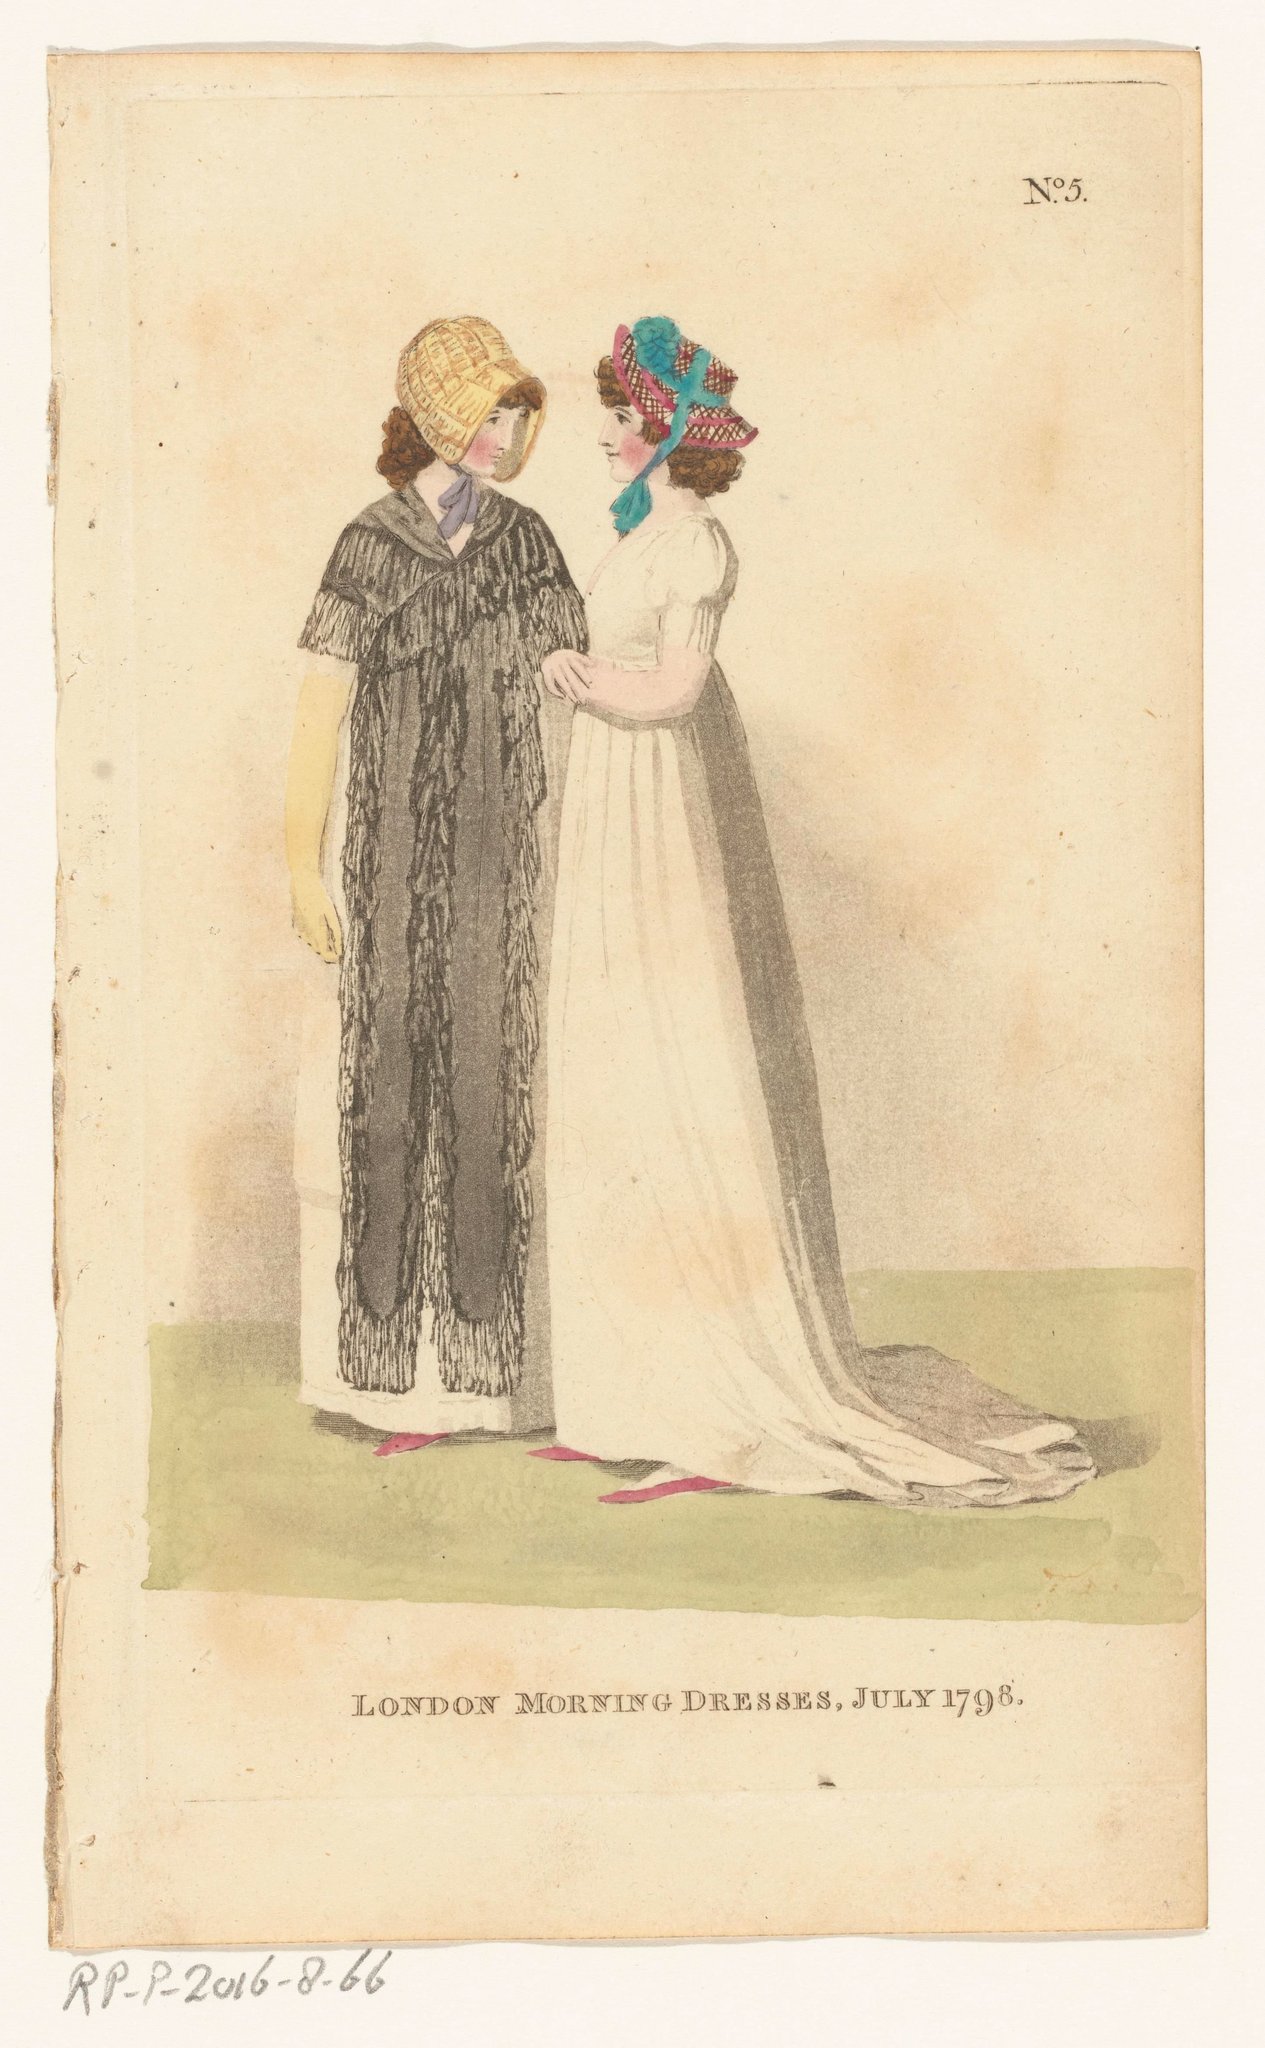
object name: fashion print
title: Magazine of Female Fashions of London and Paris, No. 5: London Morning Dresses, July 1798.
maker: richard phillips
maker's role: bookseller, publisher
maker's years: 1767-1840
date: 1798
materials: paper, ink, watercolor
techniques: aquatint, engraving, etching, hand coloring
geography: london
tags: gloves, mittens (long gloves) (+ women's clothes), dress, gown: morning dress (+ women's clothes), fashion plates, head-gear: hat (+ women's clothes)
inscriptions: : ‘London Morning Dresses, July 1798.’, collector's mark: Lugt 2228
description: Twee Londense ochtendjaponnen, juli 1798.